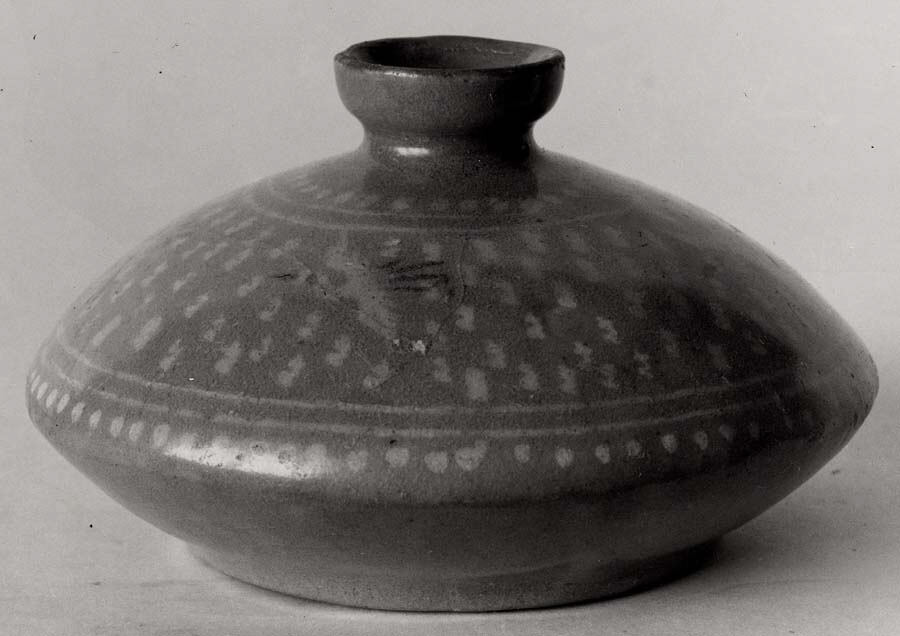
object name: bottle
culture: korean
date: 1267-1333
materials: clay